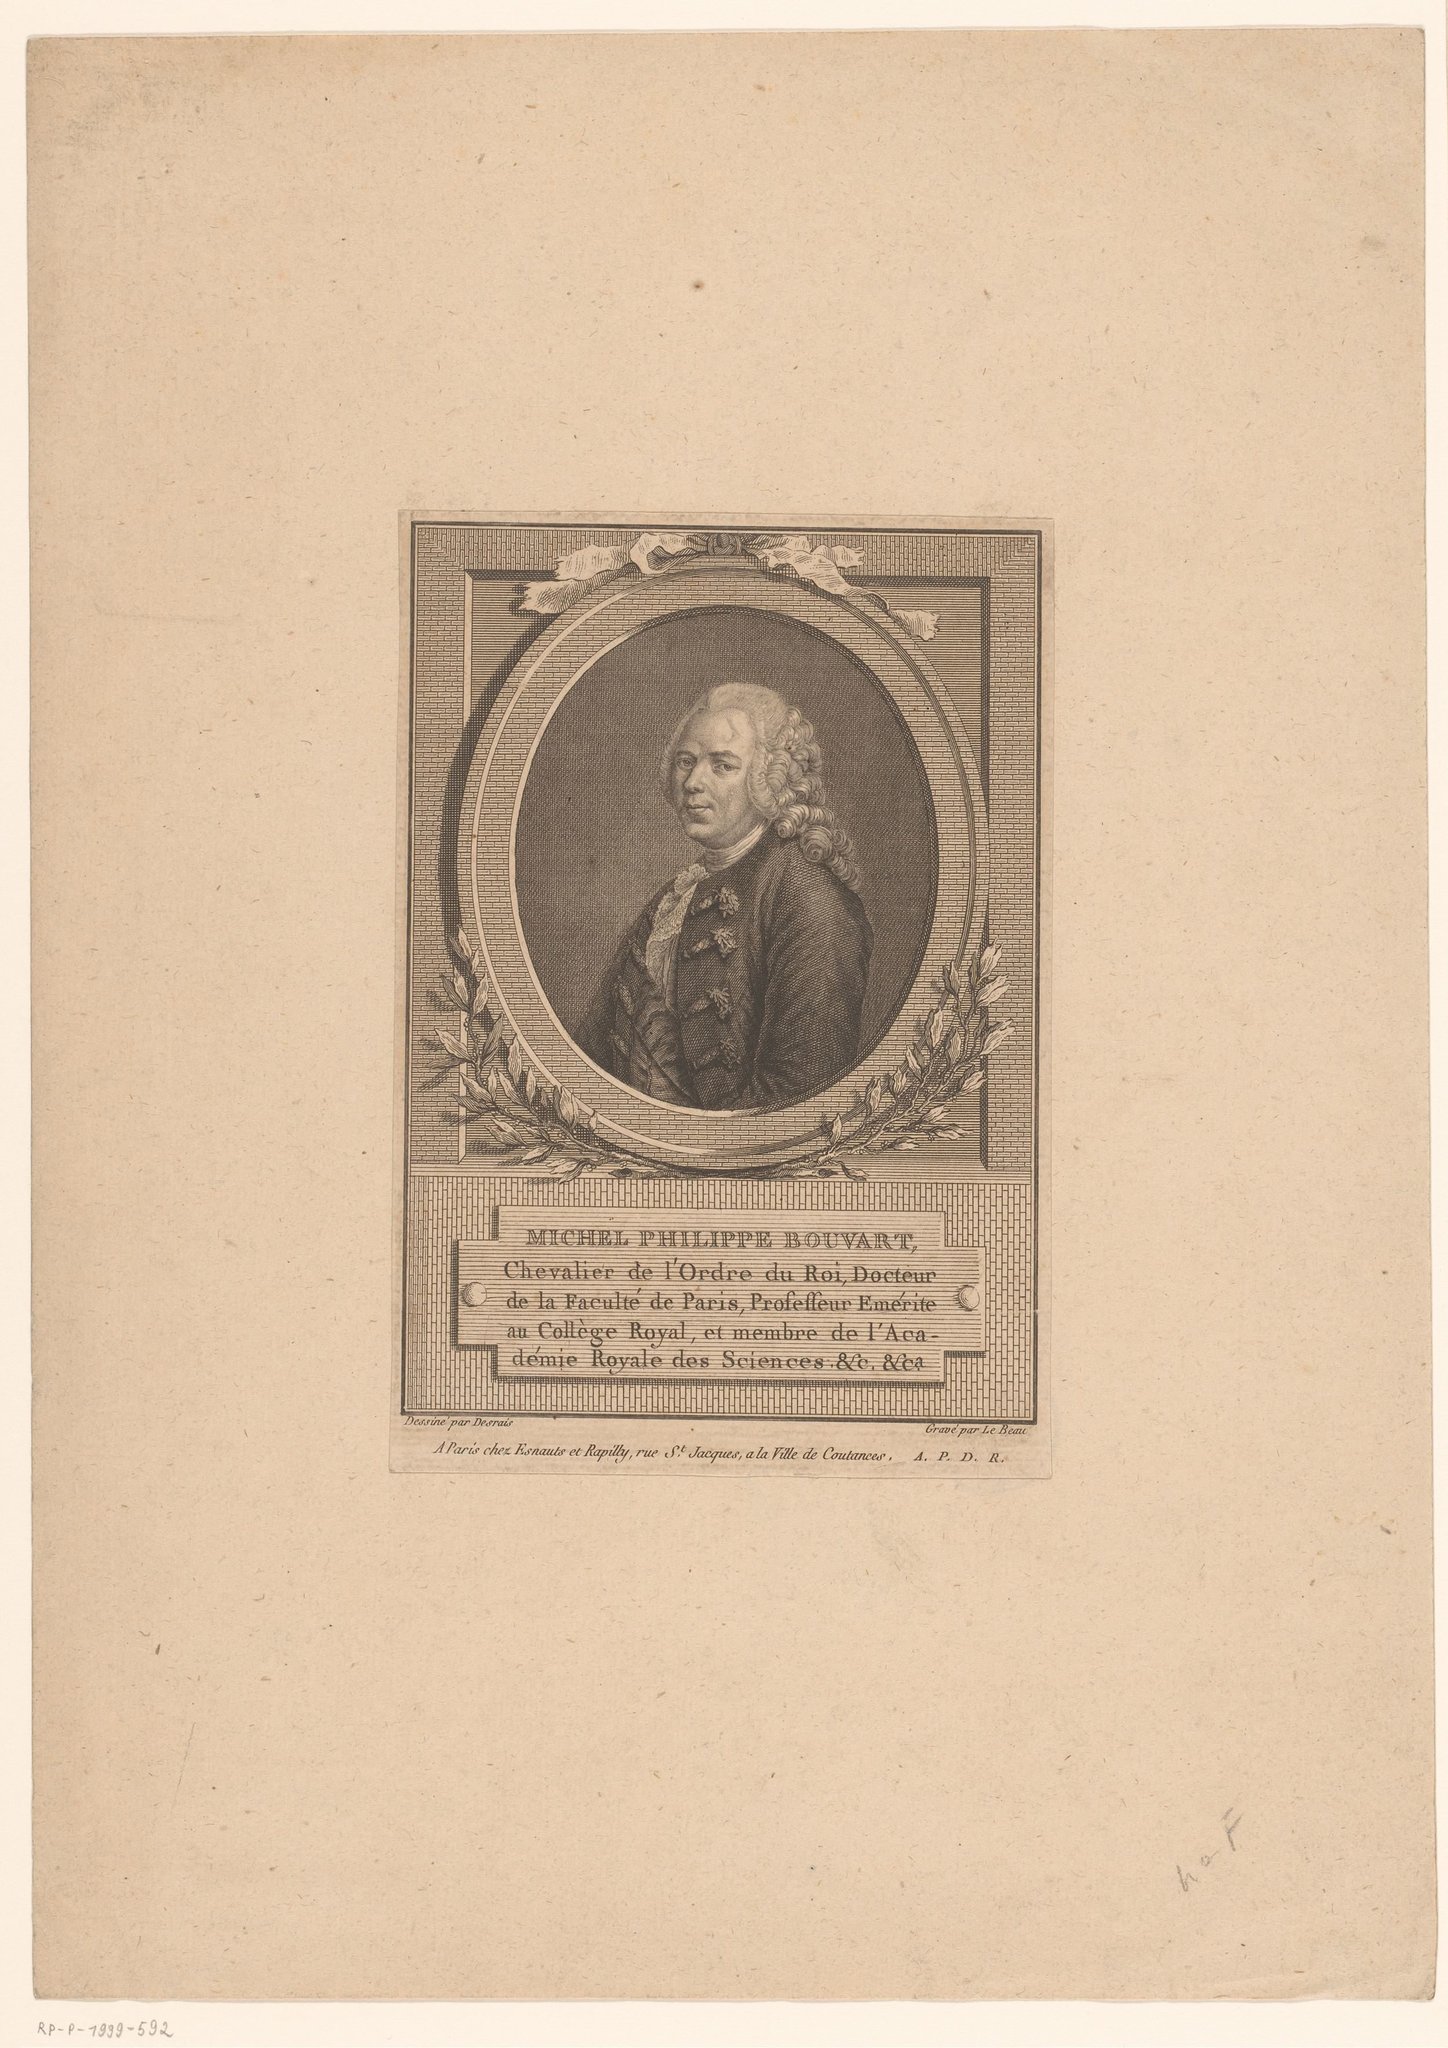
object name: print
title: Portret van Michel-Philippe Bouvart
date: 1758-1806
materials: paper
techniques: engraving, etching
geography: paris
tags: ornament ~ medallion, historical persons, physician, doctor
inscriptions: collector's mark: Lugt 2698